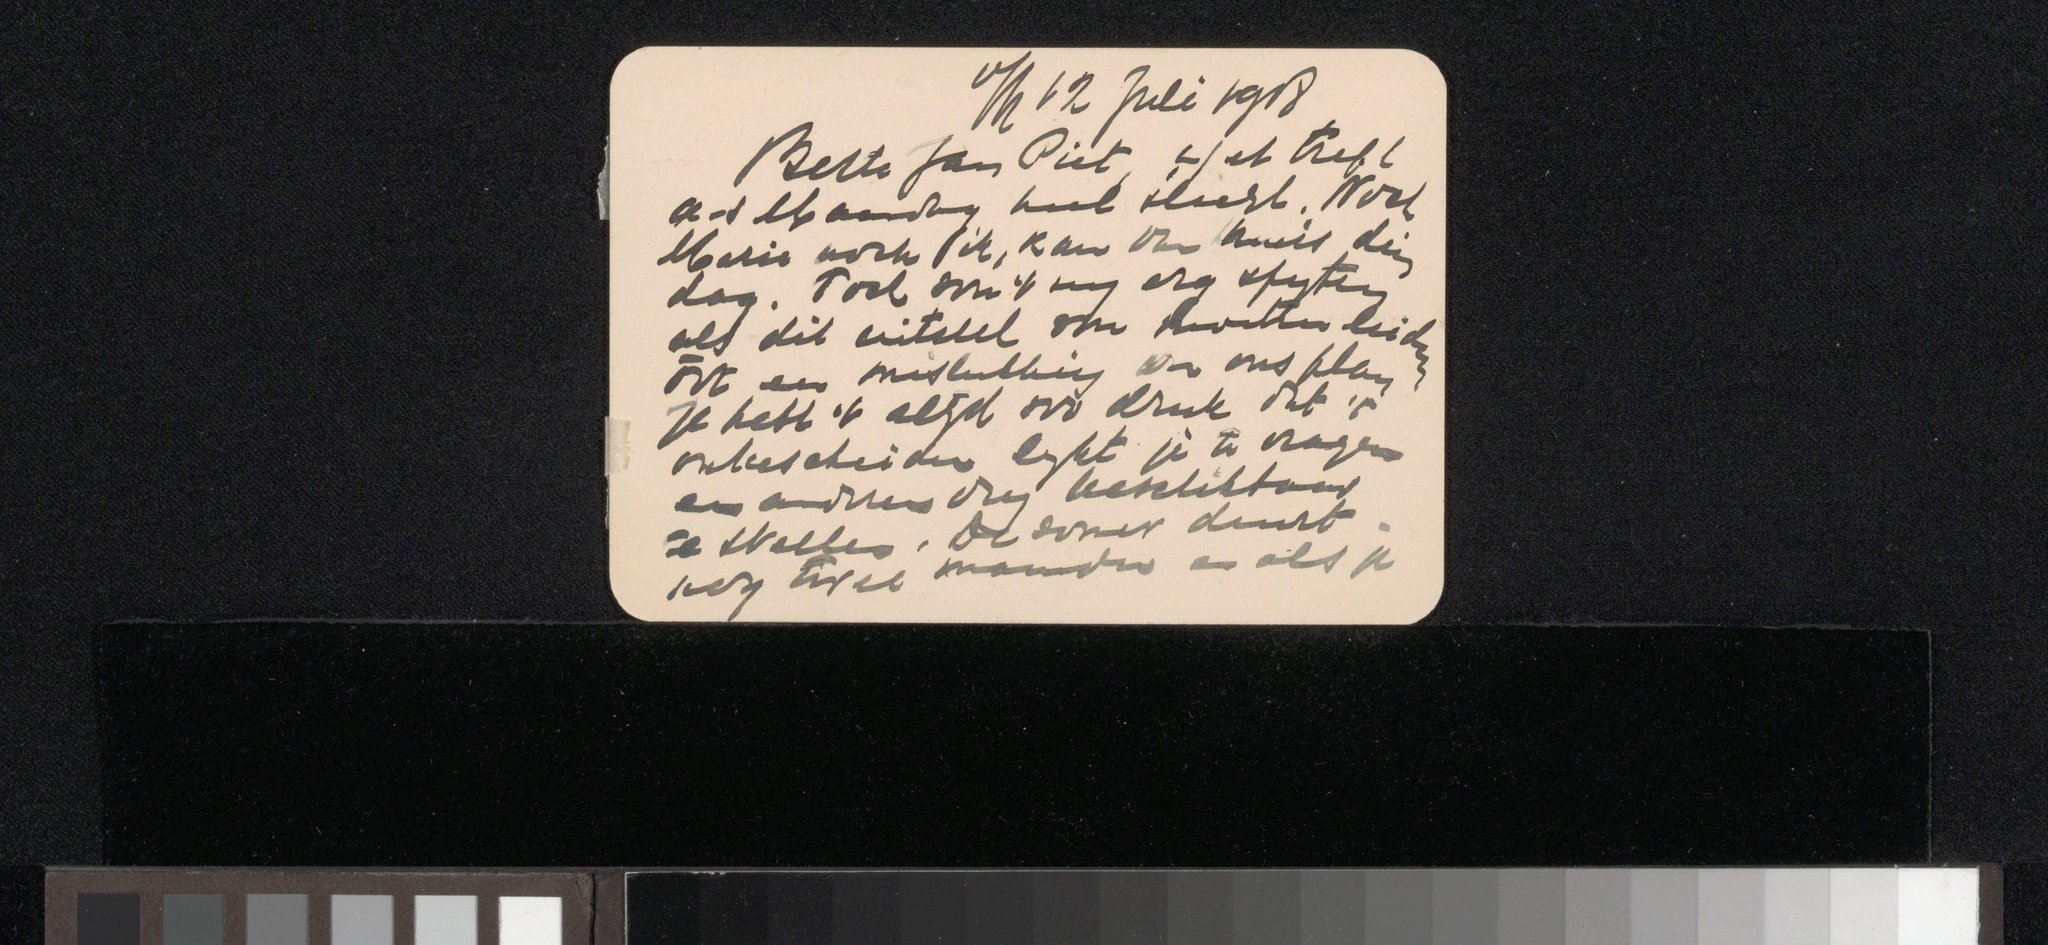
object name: letter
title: Brief aan Jan Veth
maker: willem witsen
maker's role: draughtsman, painter, print maker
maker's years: 1860-1923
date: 1918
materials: cardboard, ink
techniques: pen, writing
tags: dordrecht, amsterdam, painter, print maker, draughtsman, designer, jan veth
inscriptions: collector's mark: ‘RPK’